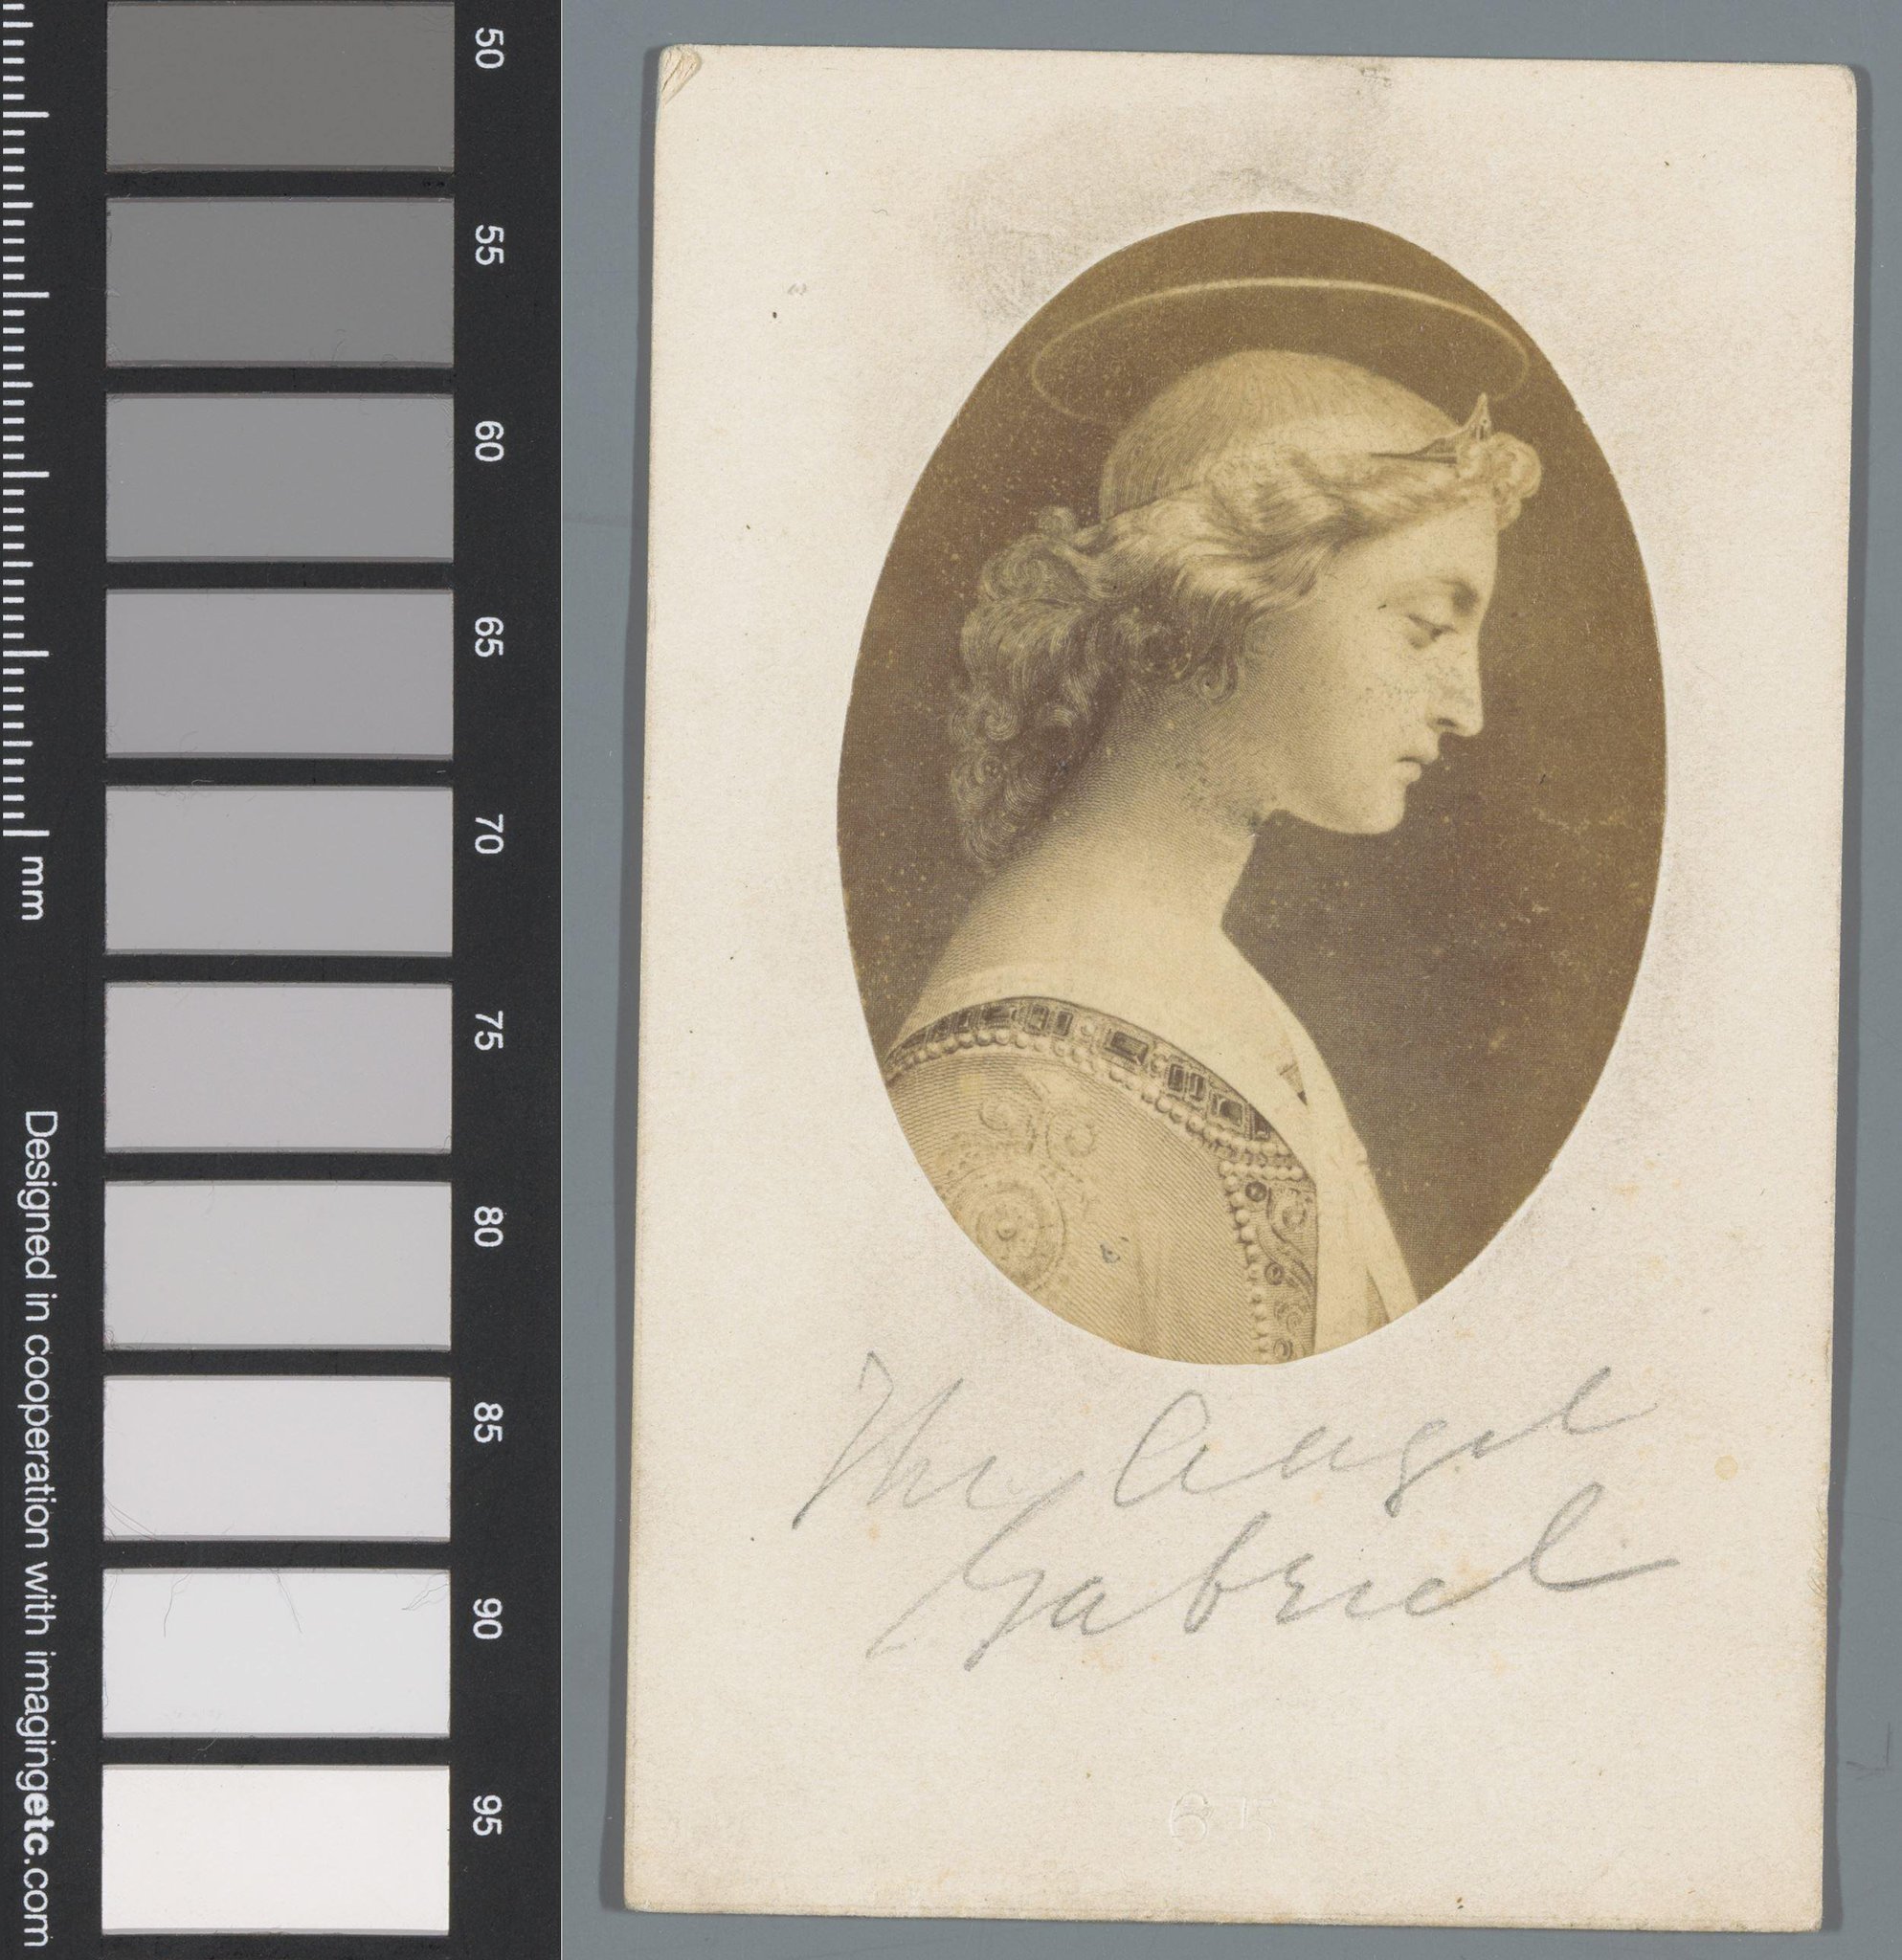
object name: reproduction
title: Fotoreproductie van The Angel Gabriel naar Paul Delaroche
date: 1855-1885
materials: cardboard, paper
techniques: albumen print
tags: the archangel gabriel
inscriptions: inscription: ‘From JOHN JERRARD,/ 172, Fleet Street, London. E.C./ DEPOT FOR PHOTOGRAPHIC/ AND OTHER SCRAPS/ OF EVERY DESCRIPTION.’